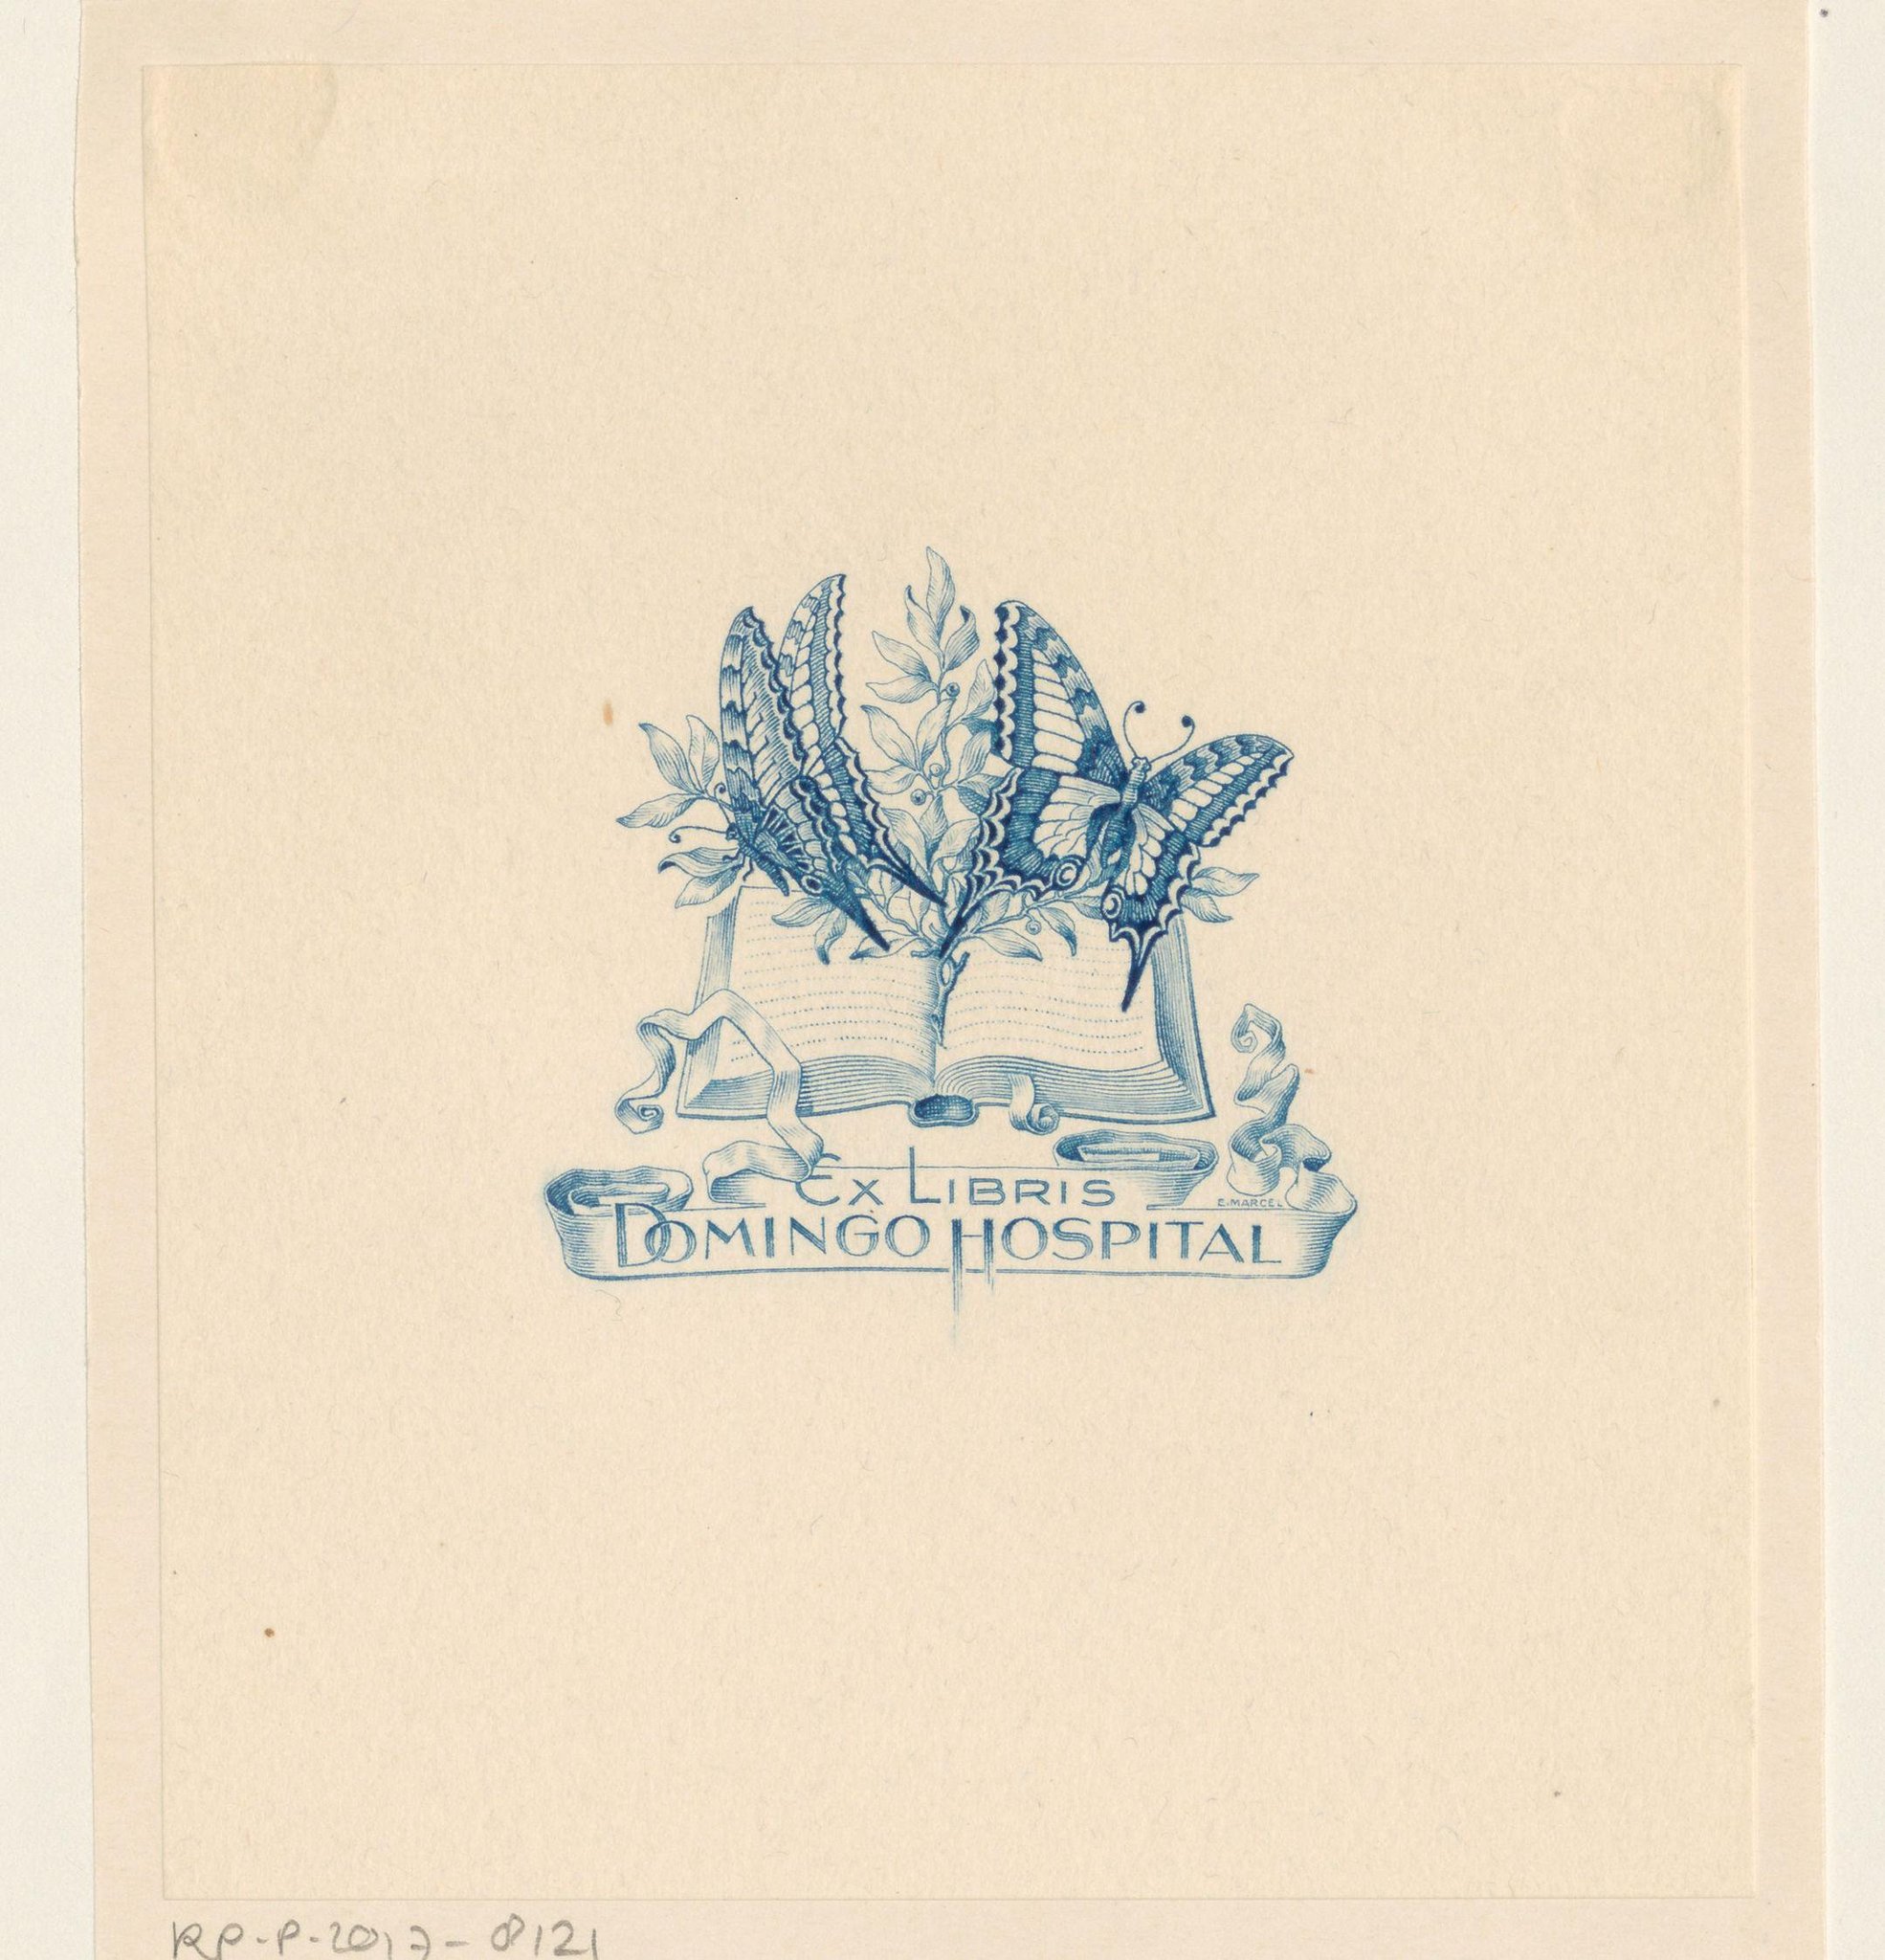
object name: bookplate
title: Ex libris van Domingo Hospital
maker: e. marcel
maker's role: print maker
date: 1944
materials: paper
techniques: printing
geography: spain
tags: book, insects: butterfly